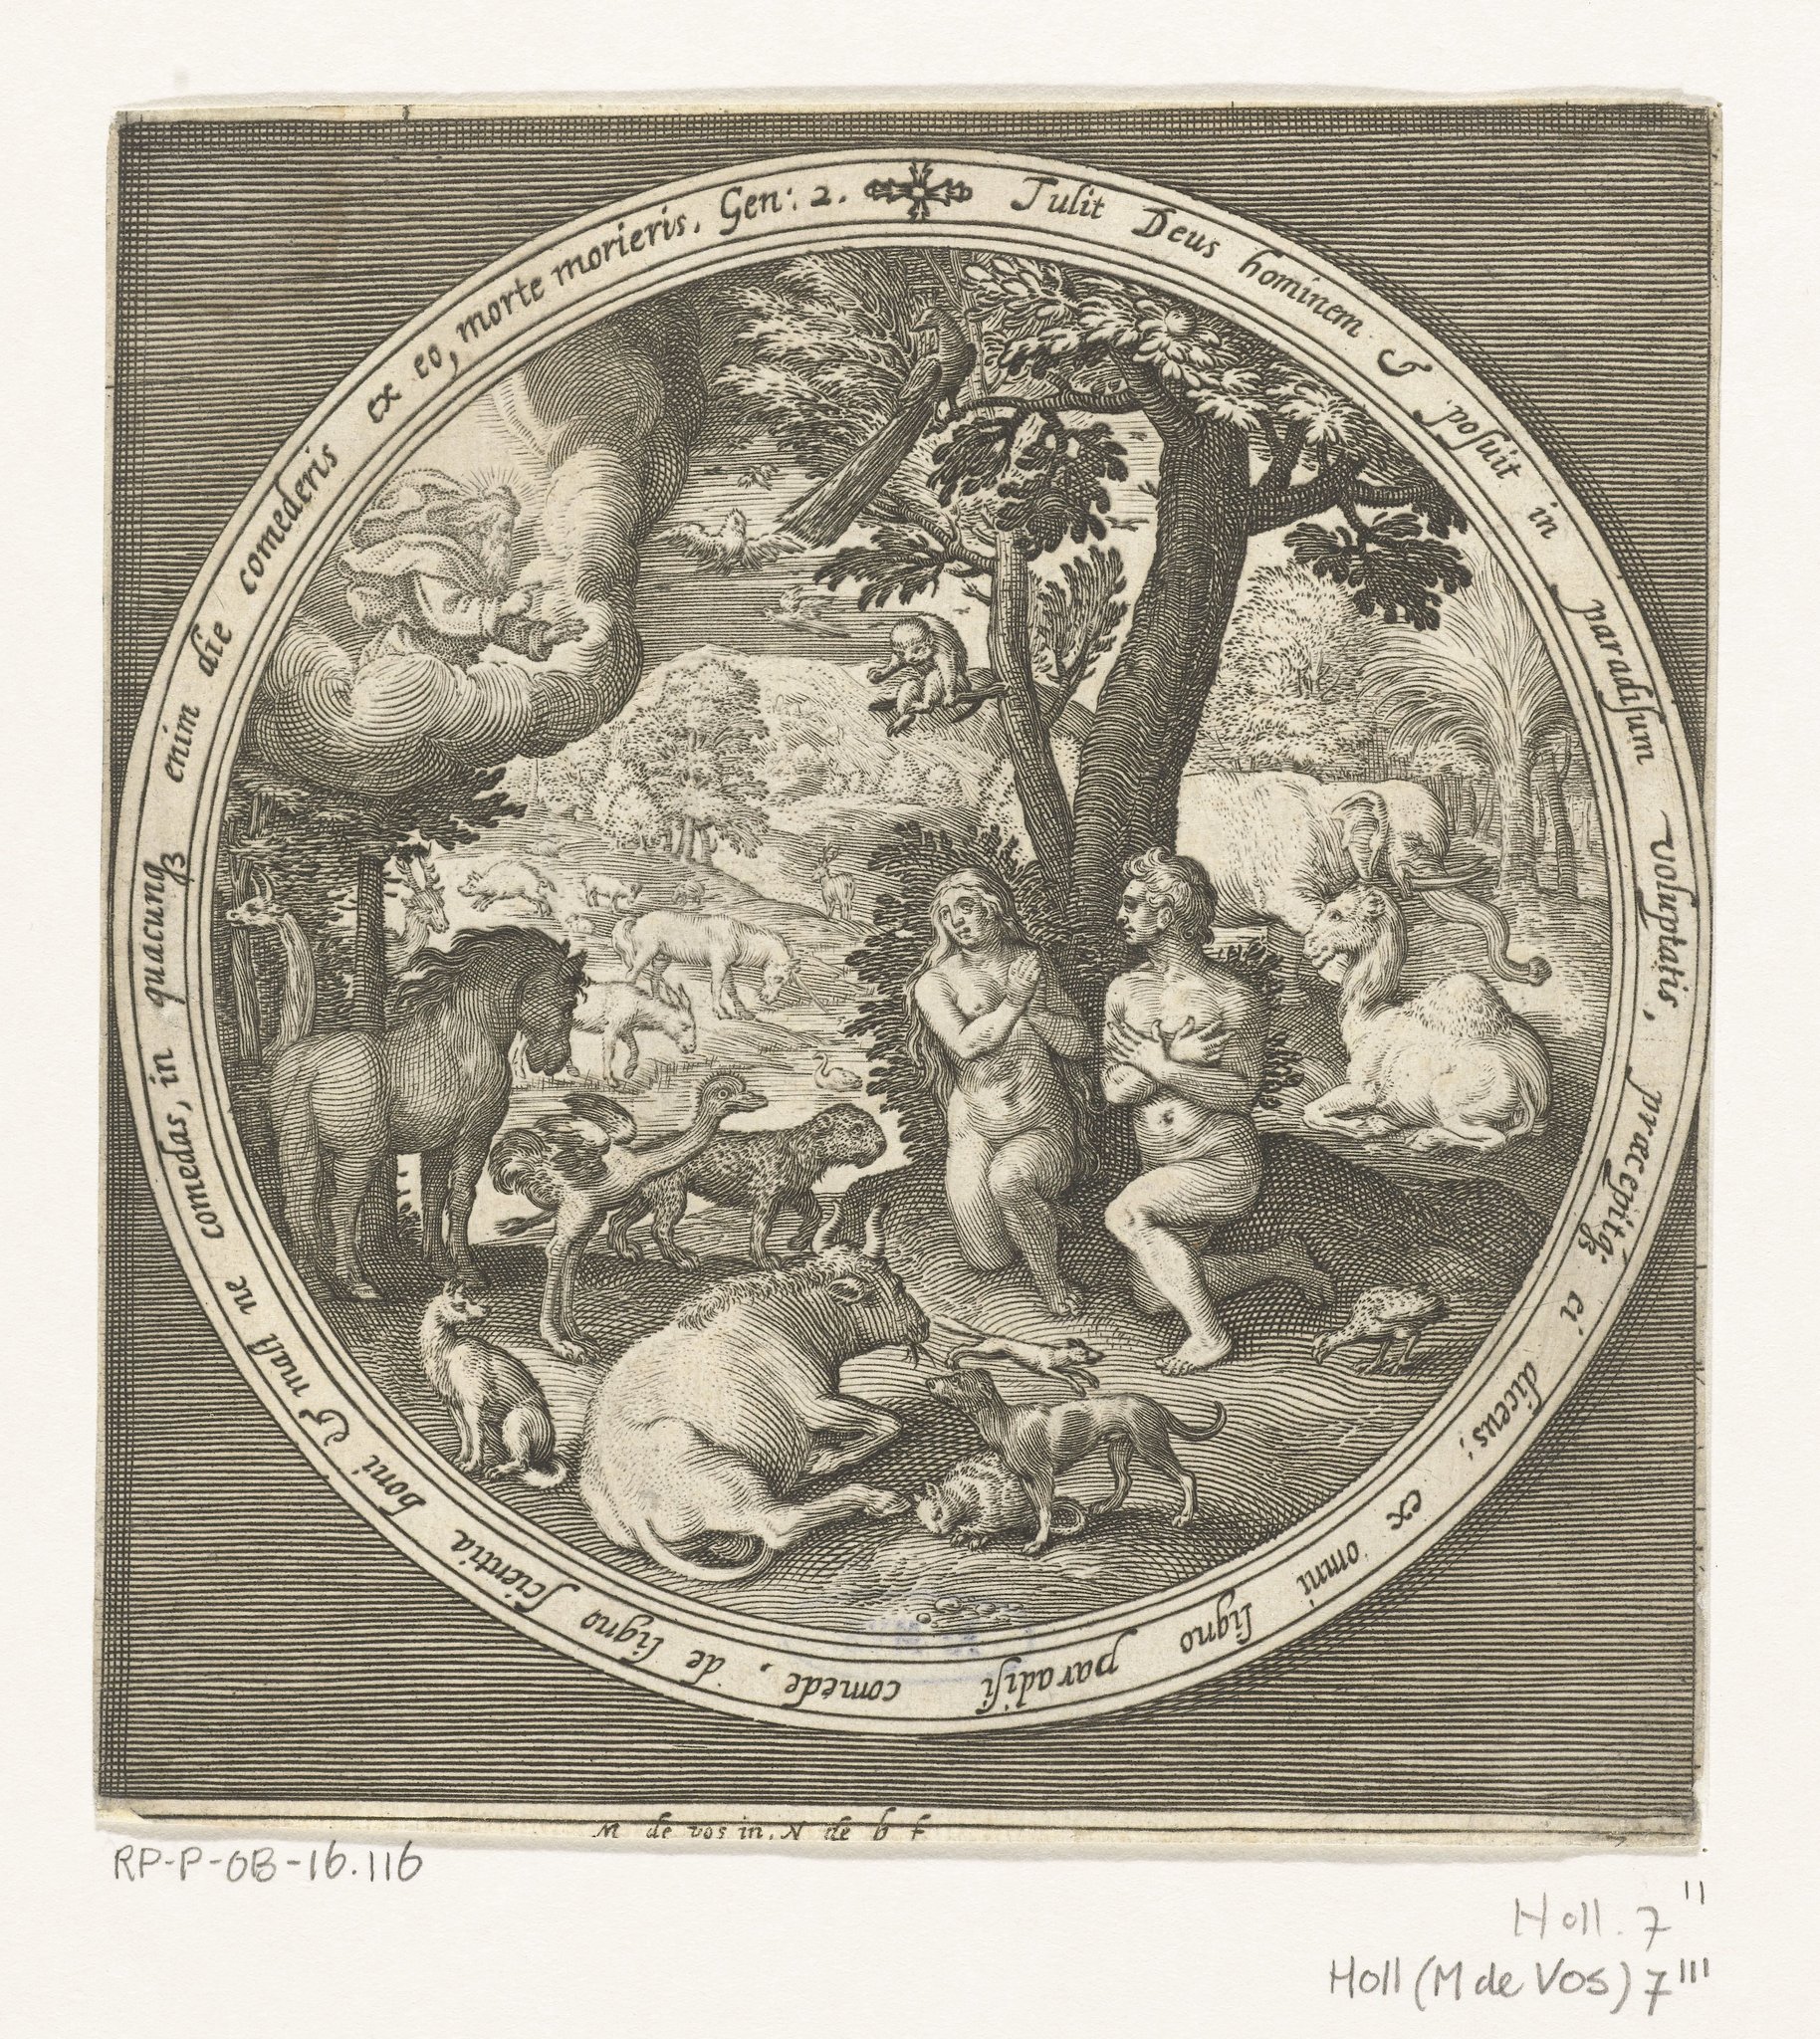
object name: print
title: Van schepping tot verdrijving uit paradijs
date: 1581-1656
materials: paper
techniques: engraving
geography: netherlands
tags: adam and eve in paradise (before the fall)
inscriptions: collector's mark: Lugt 2228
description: Adam en Eva knielen voor verschijning van God in het paradijs. In medaillon met als opschrift een bijbeltekst in Latijn uit Genesis 2, binnen rechthoekige omlijsting.